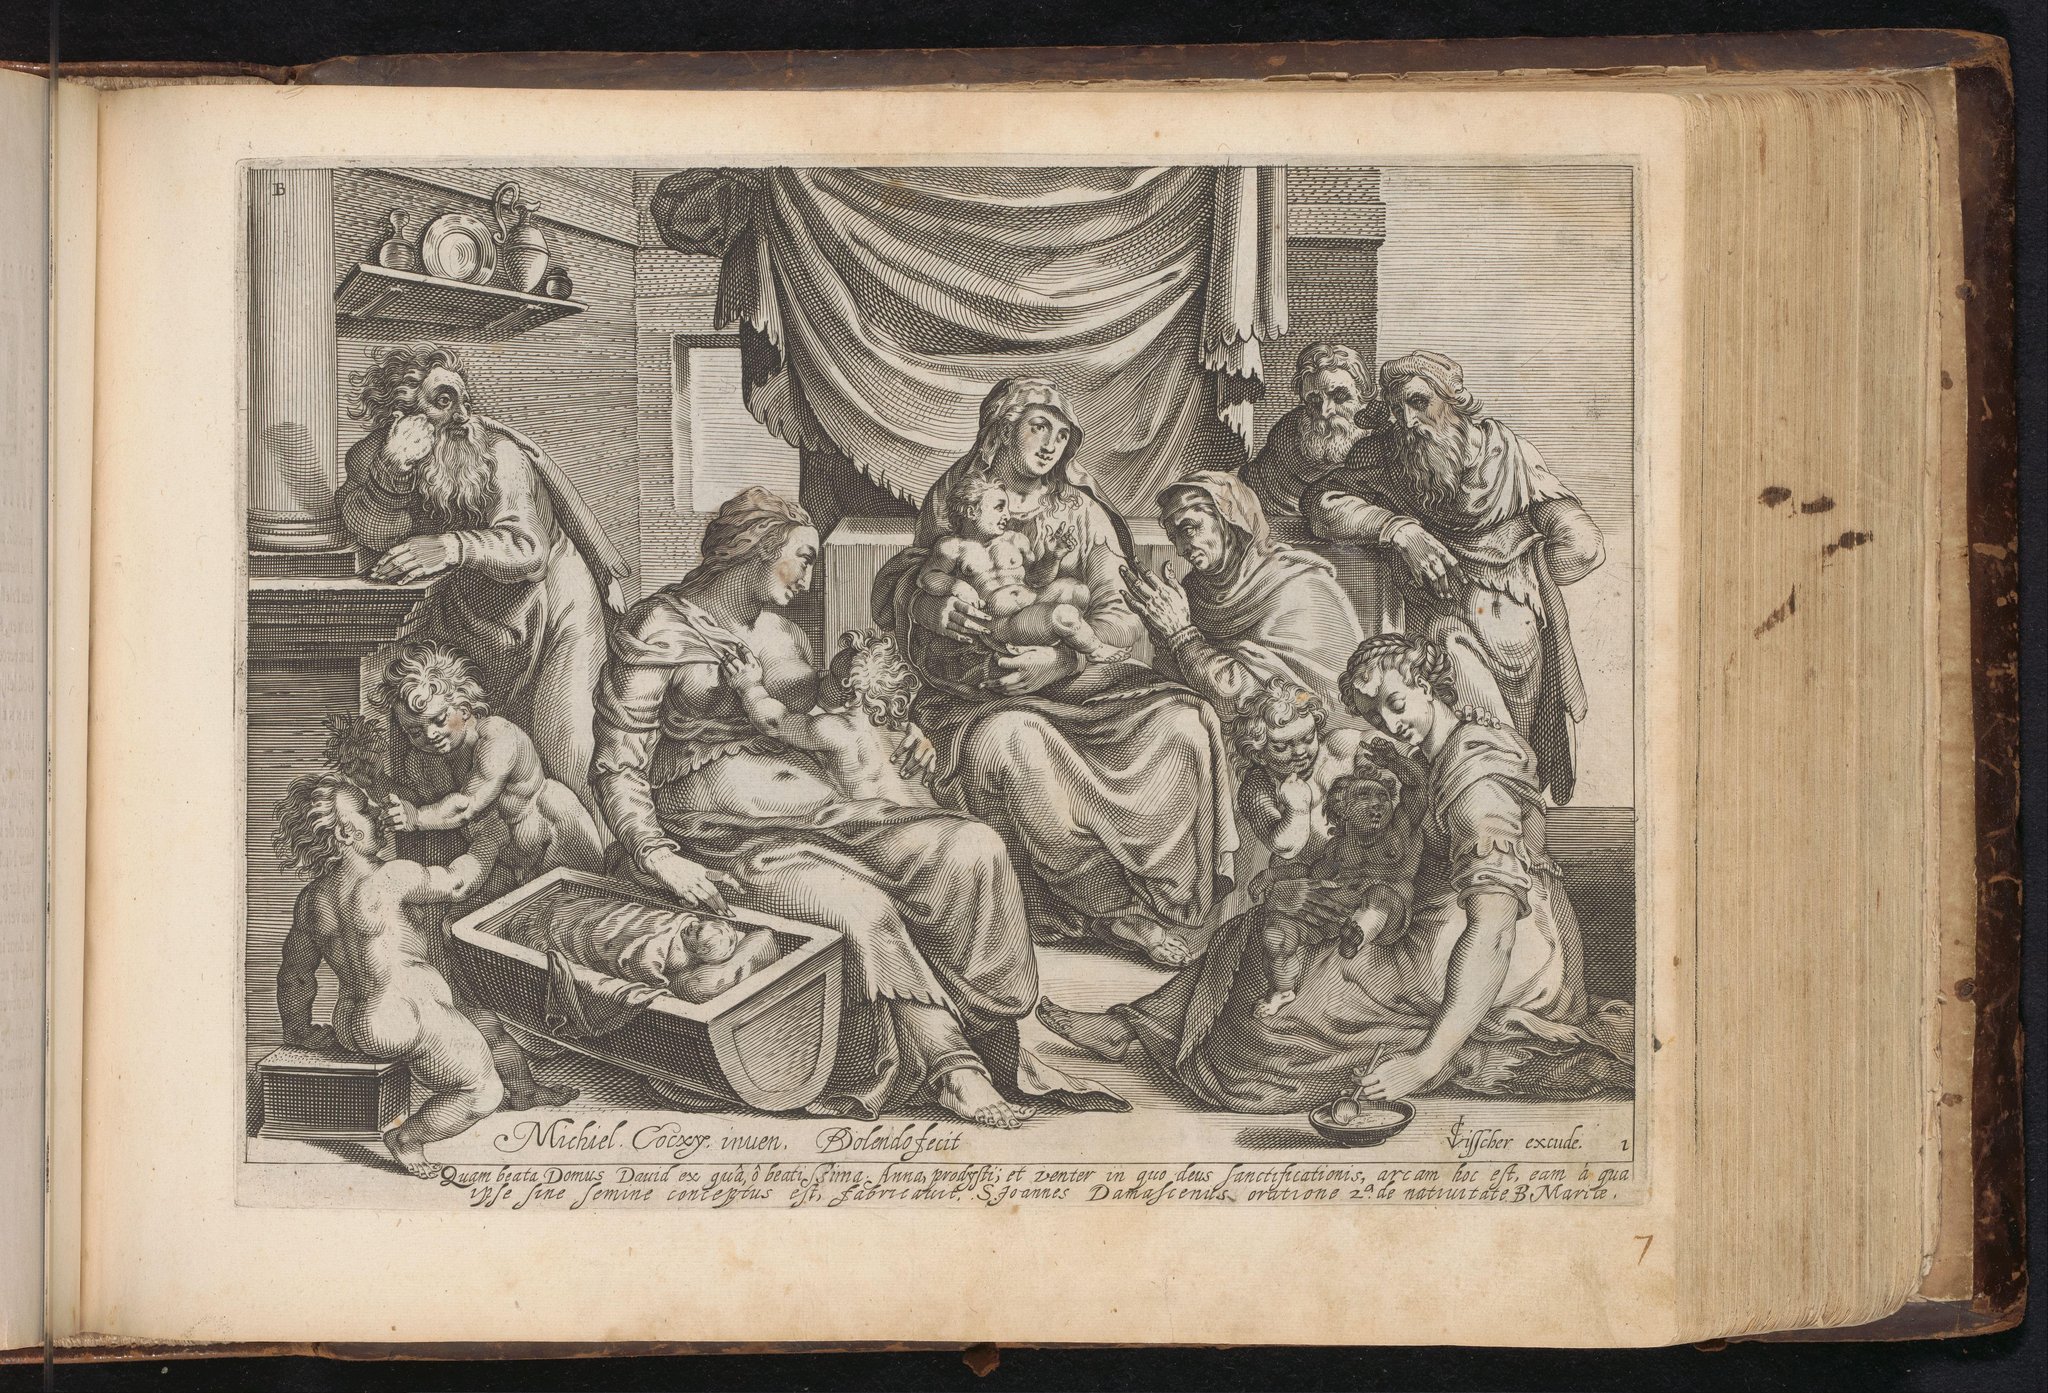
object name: album leaf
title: Jeugd van Christus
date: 1589-1626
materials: paper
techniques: engraving, hand coloring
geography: leiden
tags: holy family, and derived representations, holy kinship, extended representations of 'anna selbdritt' (joseph and joachim, three husbands, three daughters with seven children)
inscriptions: number: ‘7’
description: De Heilige Familie met de heilige Anna en andere vrouwen, mannen en kinderen in een huiskamer. Maria zit in het midden met het Christuskind op haar schoot. Anna aanbidt het Kind. Twee andere vrouwen met kleine kinderen zitten aan weerszijden van Maria. Jozef leunt links tegen een pilaar. Onder de voorstelling een tekst in het Latijn. Deze prent maakt deel uit van een album.